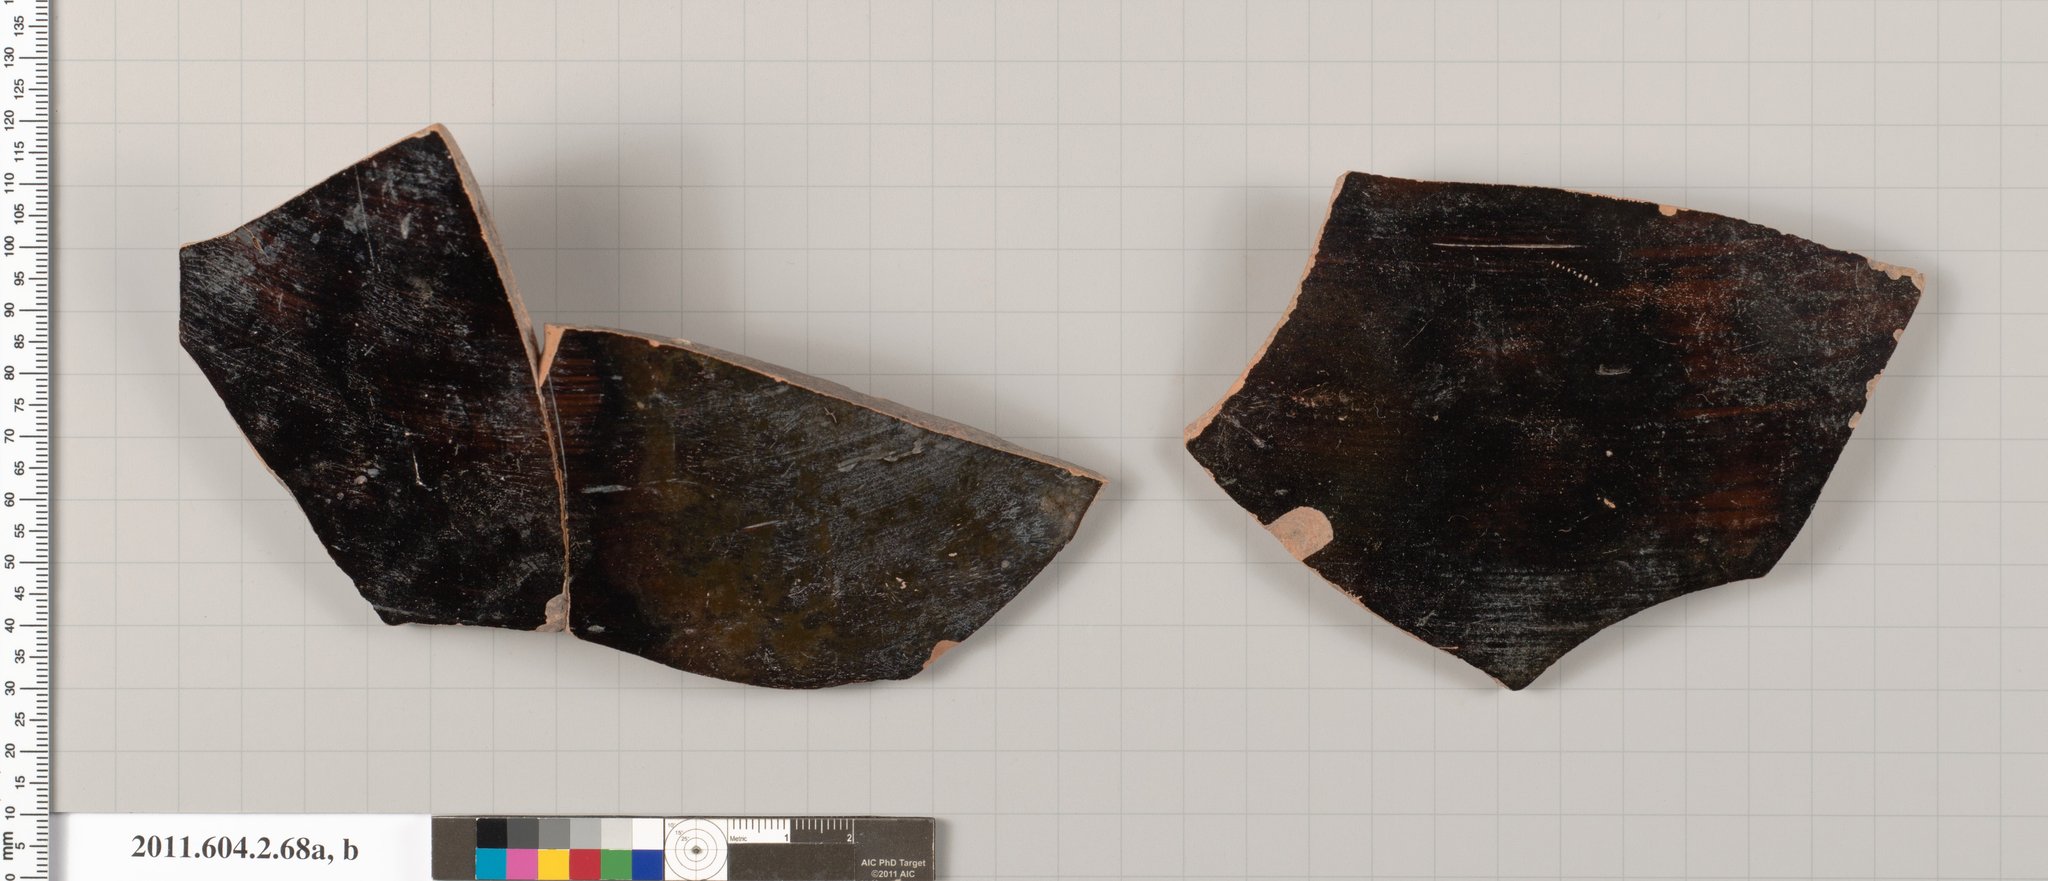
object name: amphora fragment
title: Terracotta fragments of an amphora (jar)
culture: greek, attic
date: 534-468 BCE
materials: terracotta